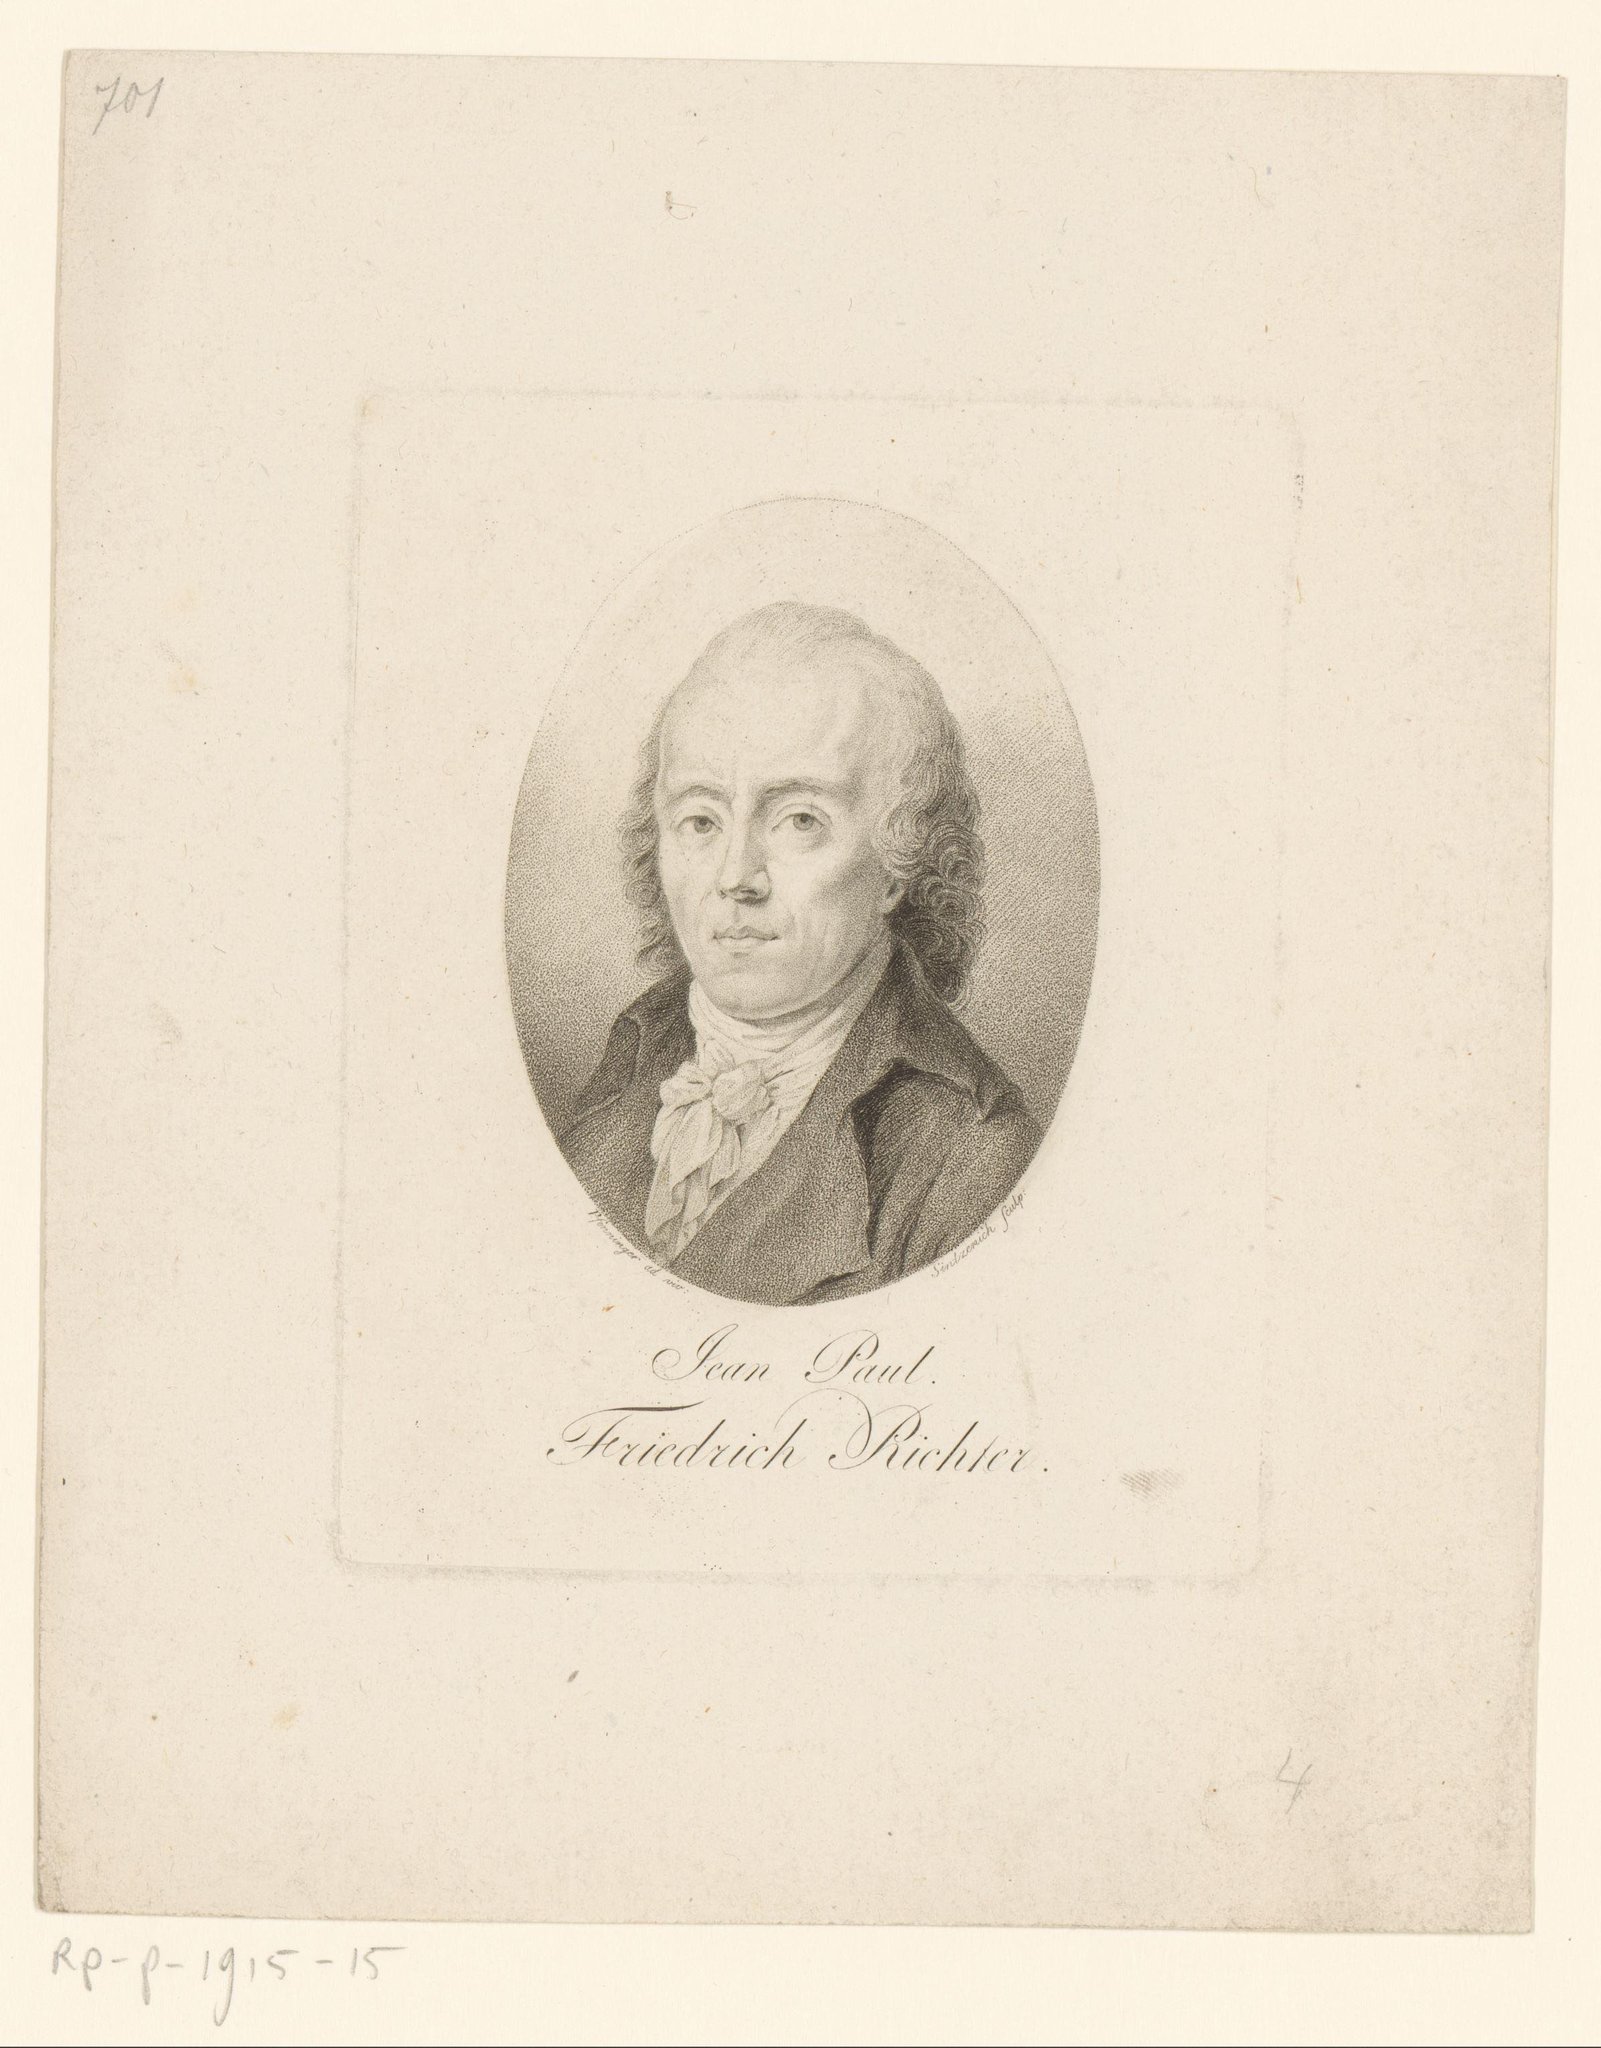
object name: print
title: Portret van Jean Paul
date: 1762-1812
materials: paper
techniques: engraving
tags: jean paul, historical persons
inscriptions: collector's mark: Lugt 2228